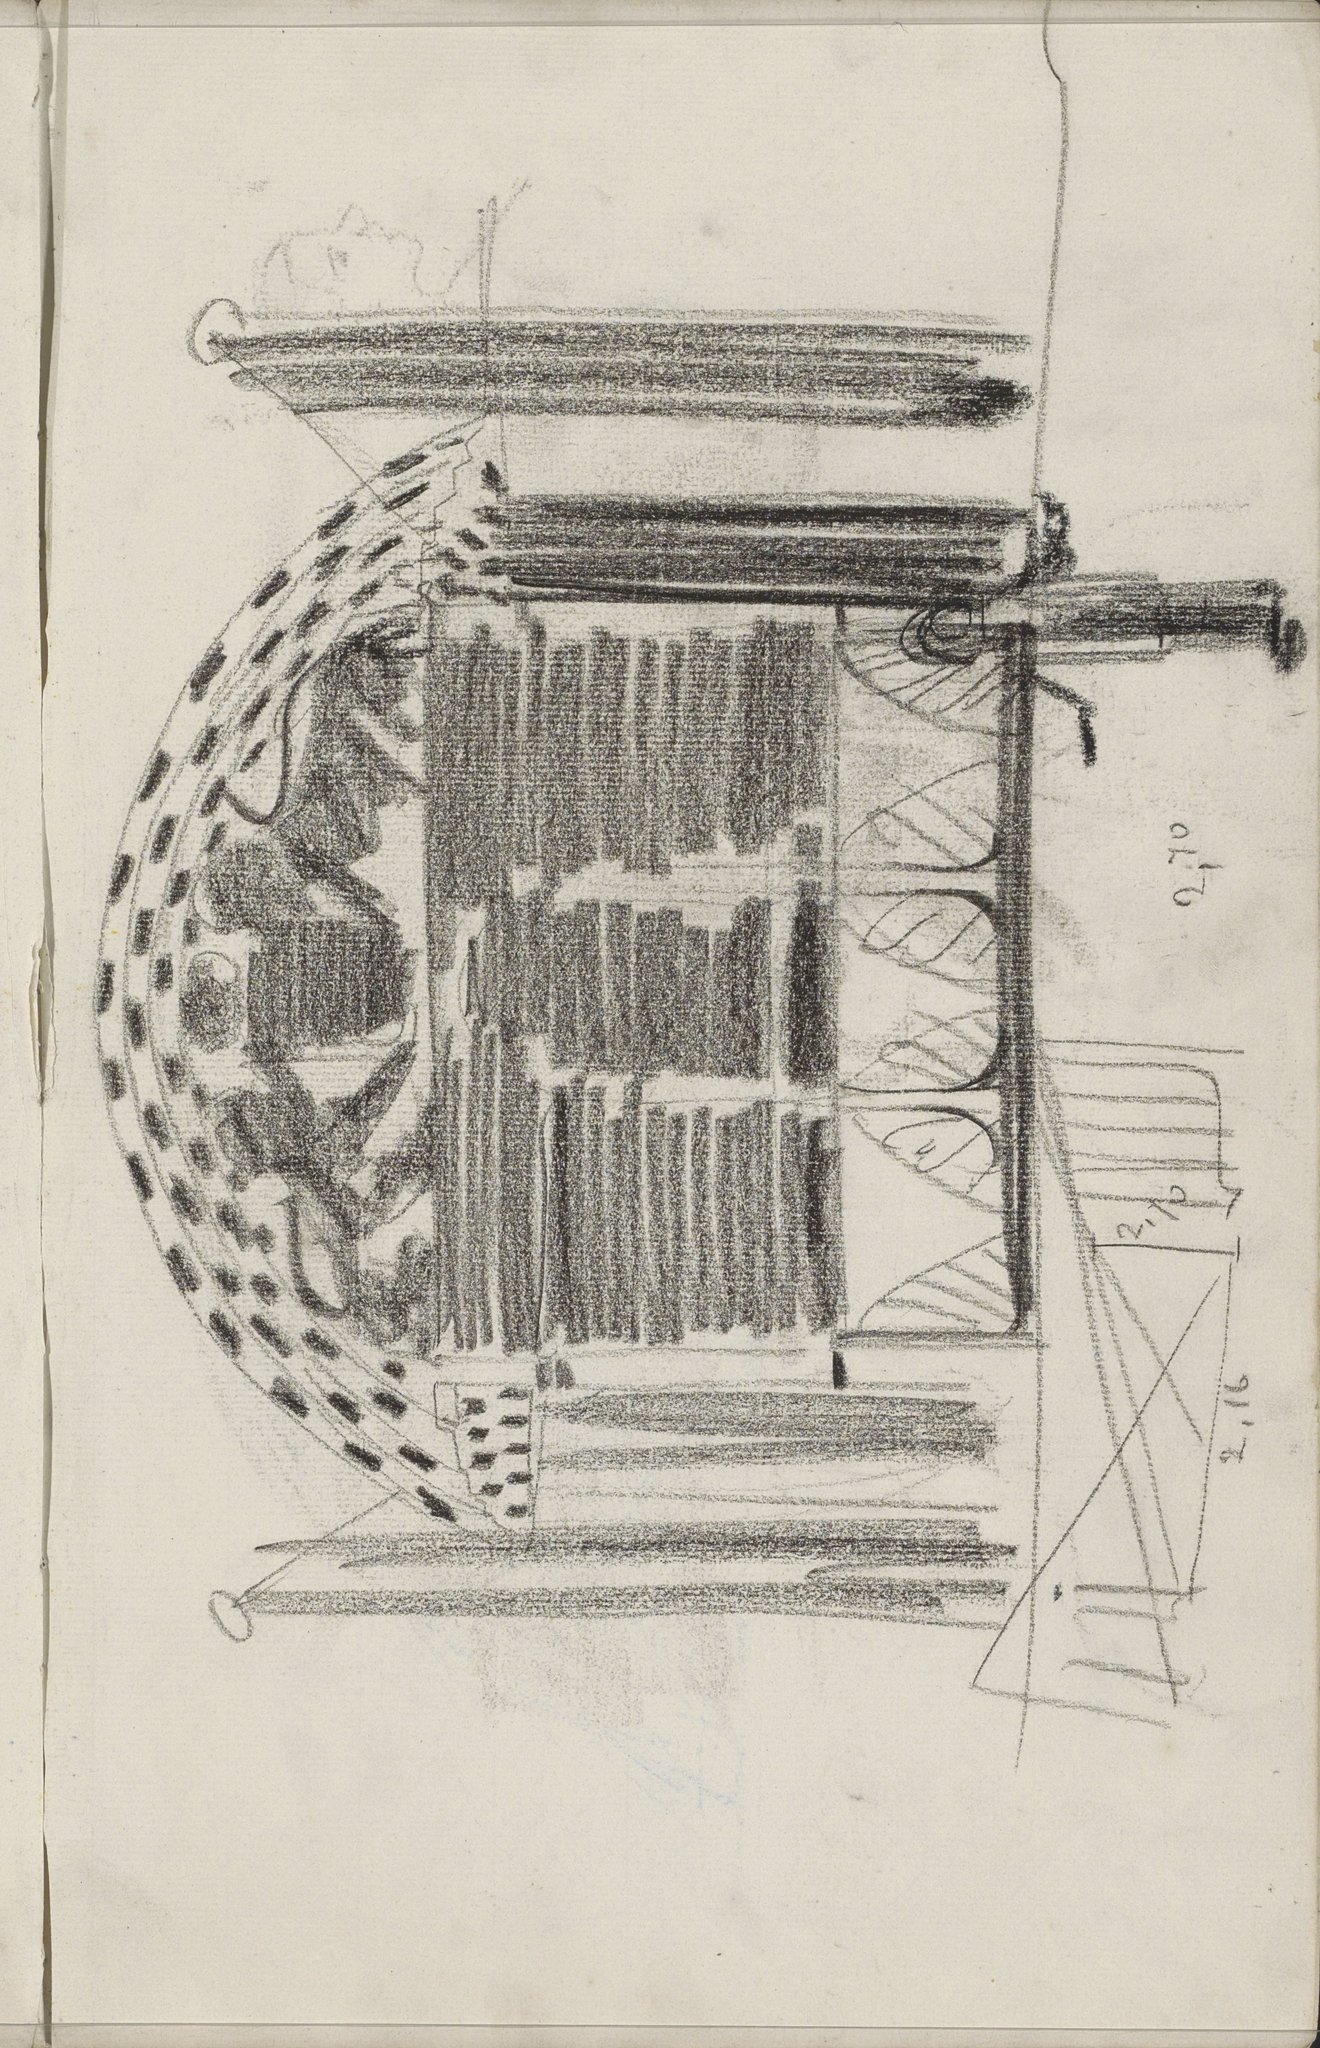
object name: sketchbook leaf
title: Gebouw met een koepel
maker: carel adolph lion cachet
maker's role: draughtsman, print maker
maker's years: 1864-1945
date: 1895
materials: chalk, paper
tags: architecture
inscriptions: annotation: ‘[...]’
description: De koepel is versierd met een stippenpatroon en twee leeuwen. Blad 15 recto uit een schetsboek met 23 bladen.